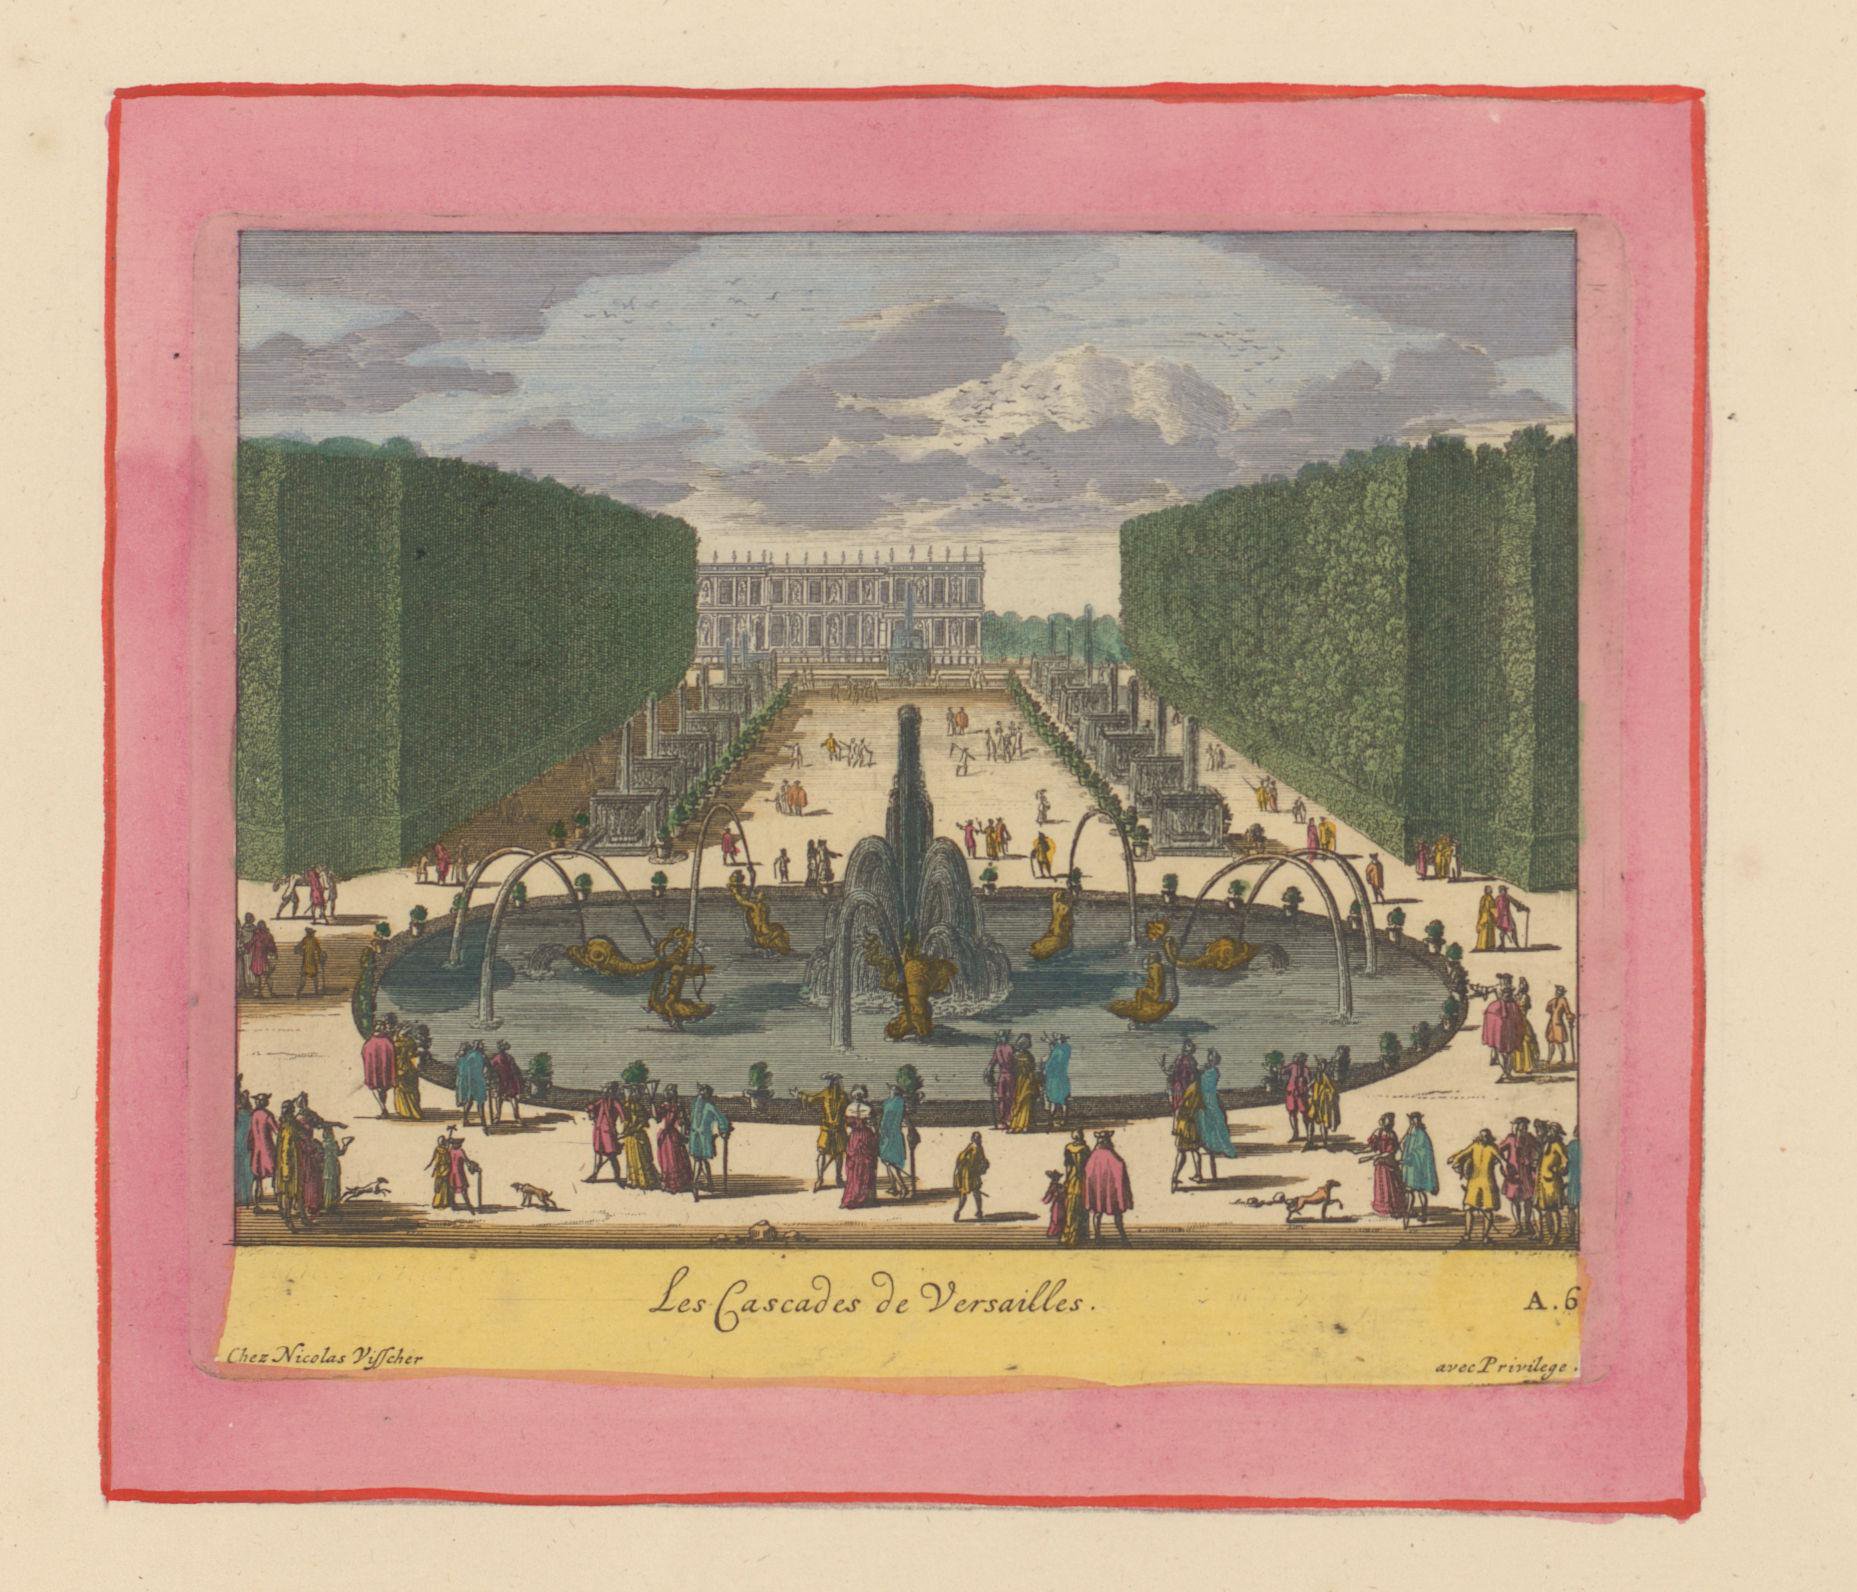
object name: album leaf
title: Les Cascades de Versailles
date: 1686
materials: paper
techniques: etching, hand coloring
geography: amsterdam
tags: garden fountain, french or architectonic garden; formal garden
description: Op de voorgrond verschillende fonteinen. Daarachter aan weerszijden van het pad verschillende cascades. Rechtsonder het serienummer: A6. Prent maakt deel uit van een album.